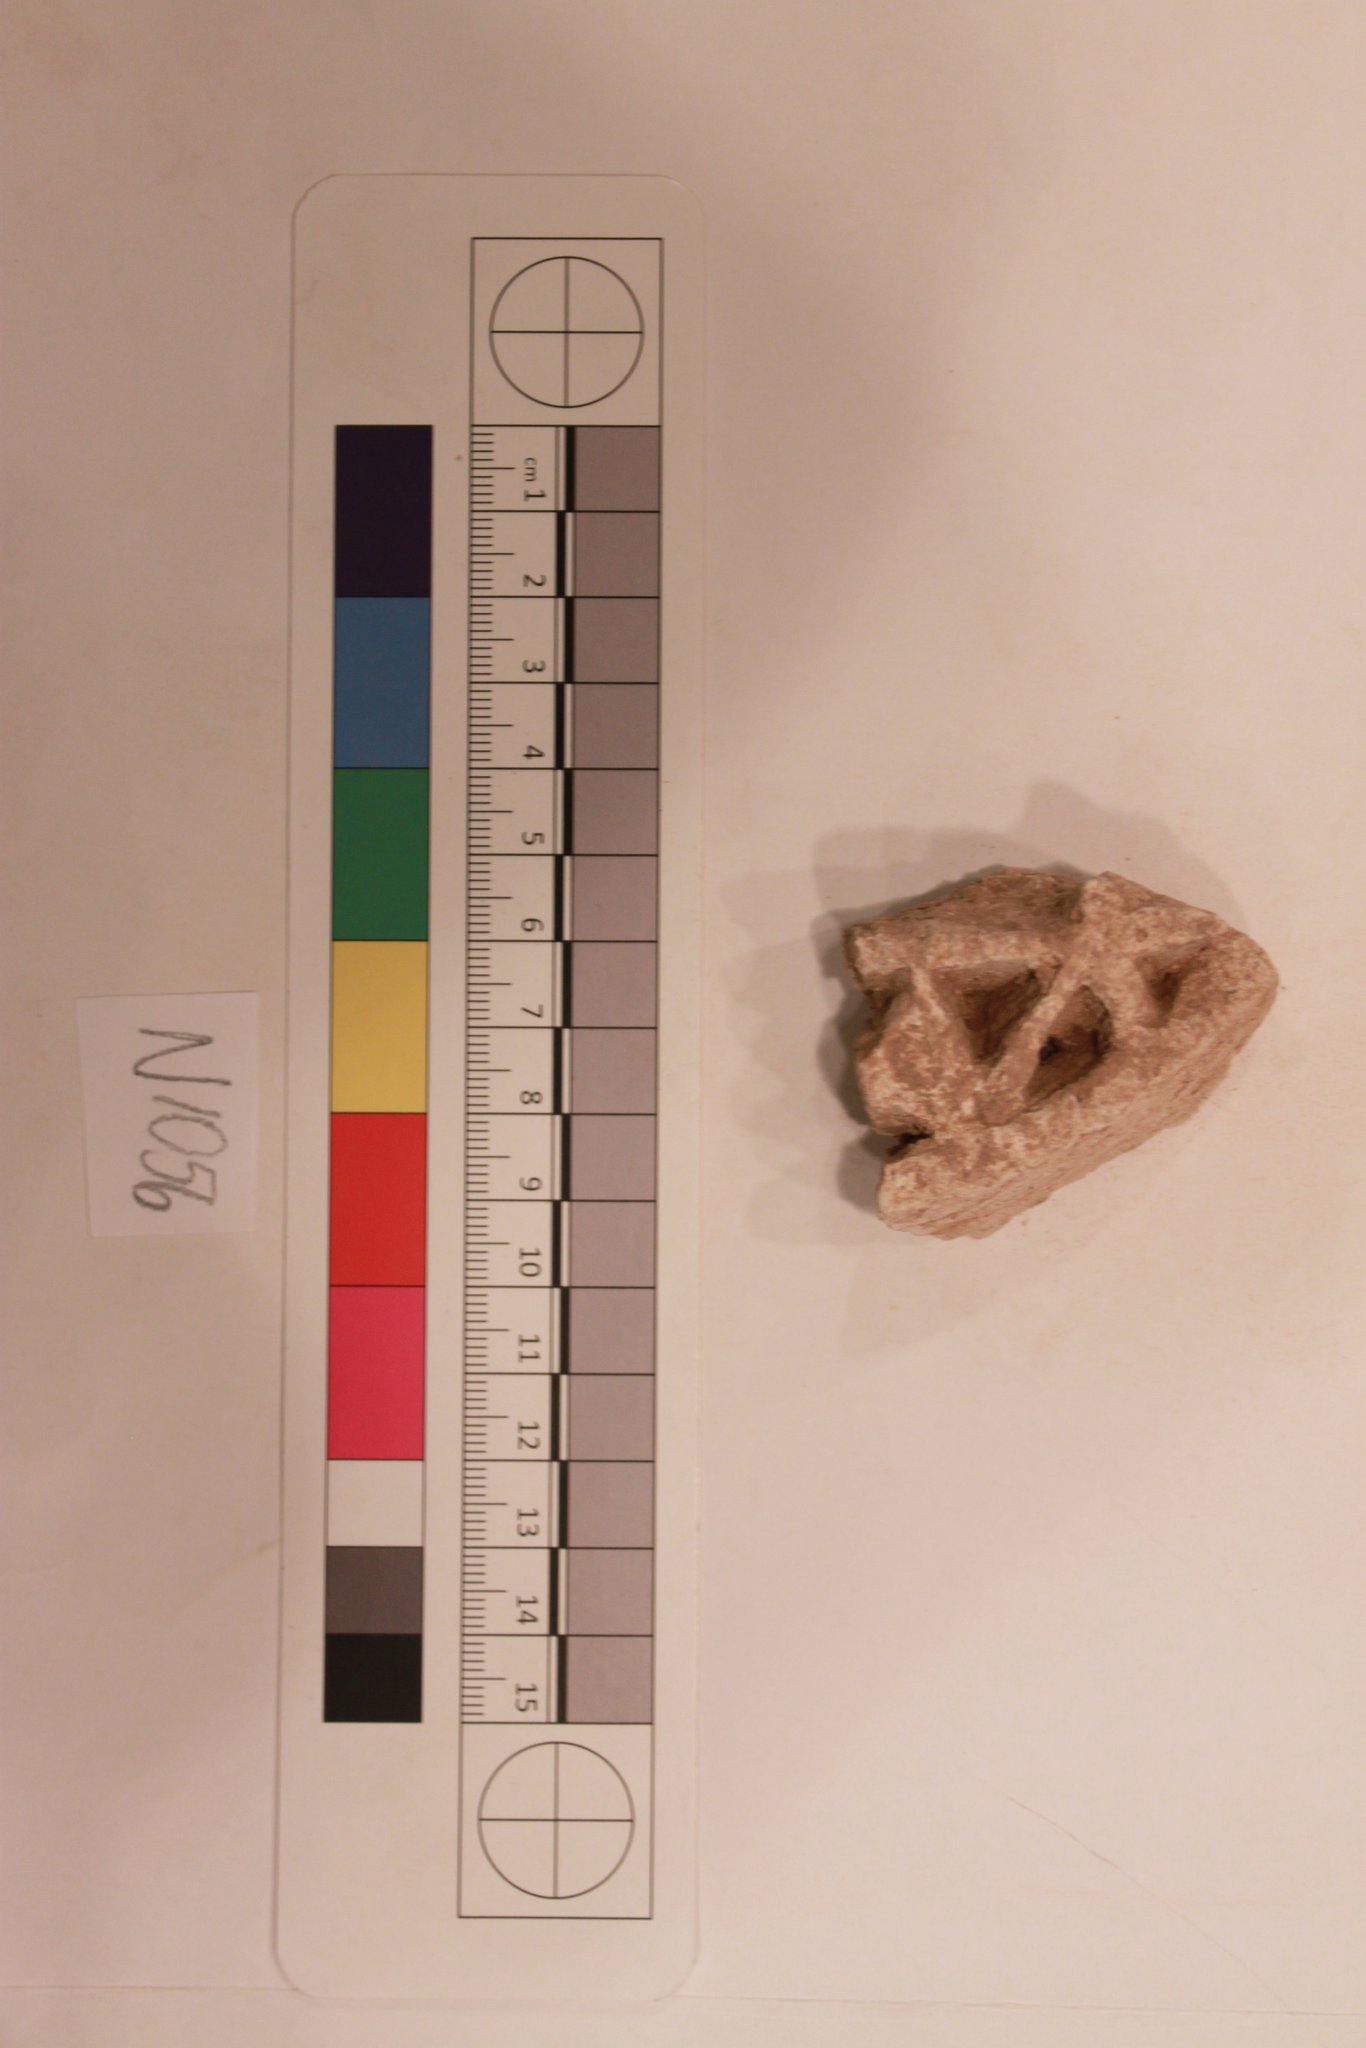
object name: fragment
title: Stucco Fragment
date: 701-1200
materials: plaster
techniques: carving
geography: iran